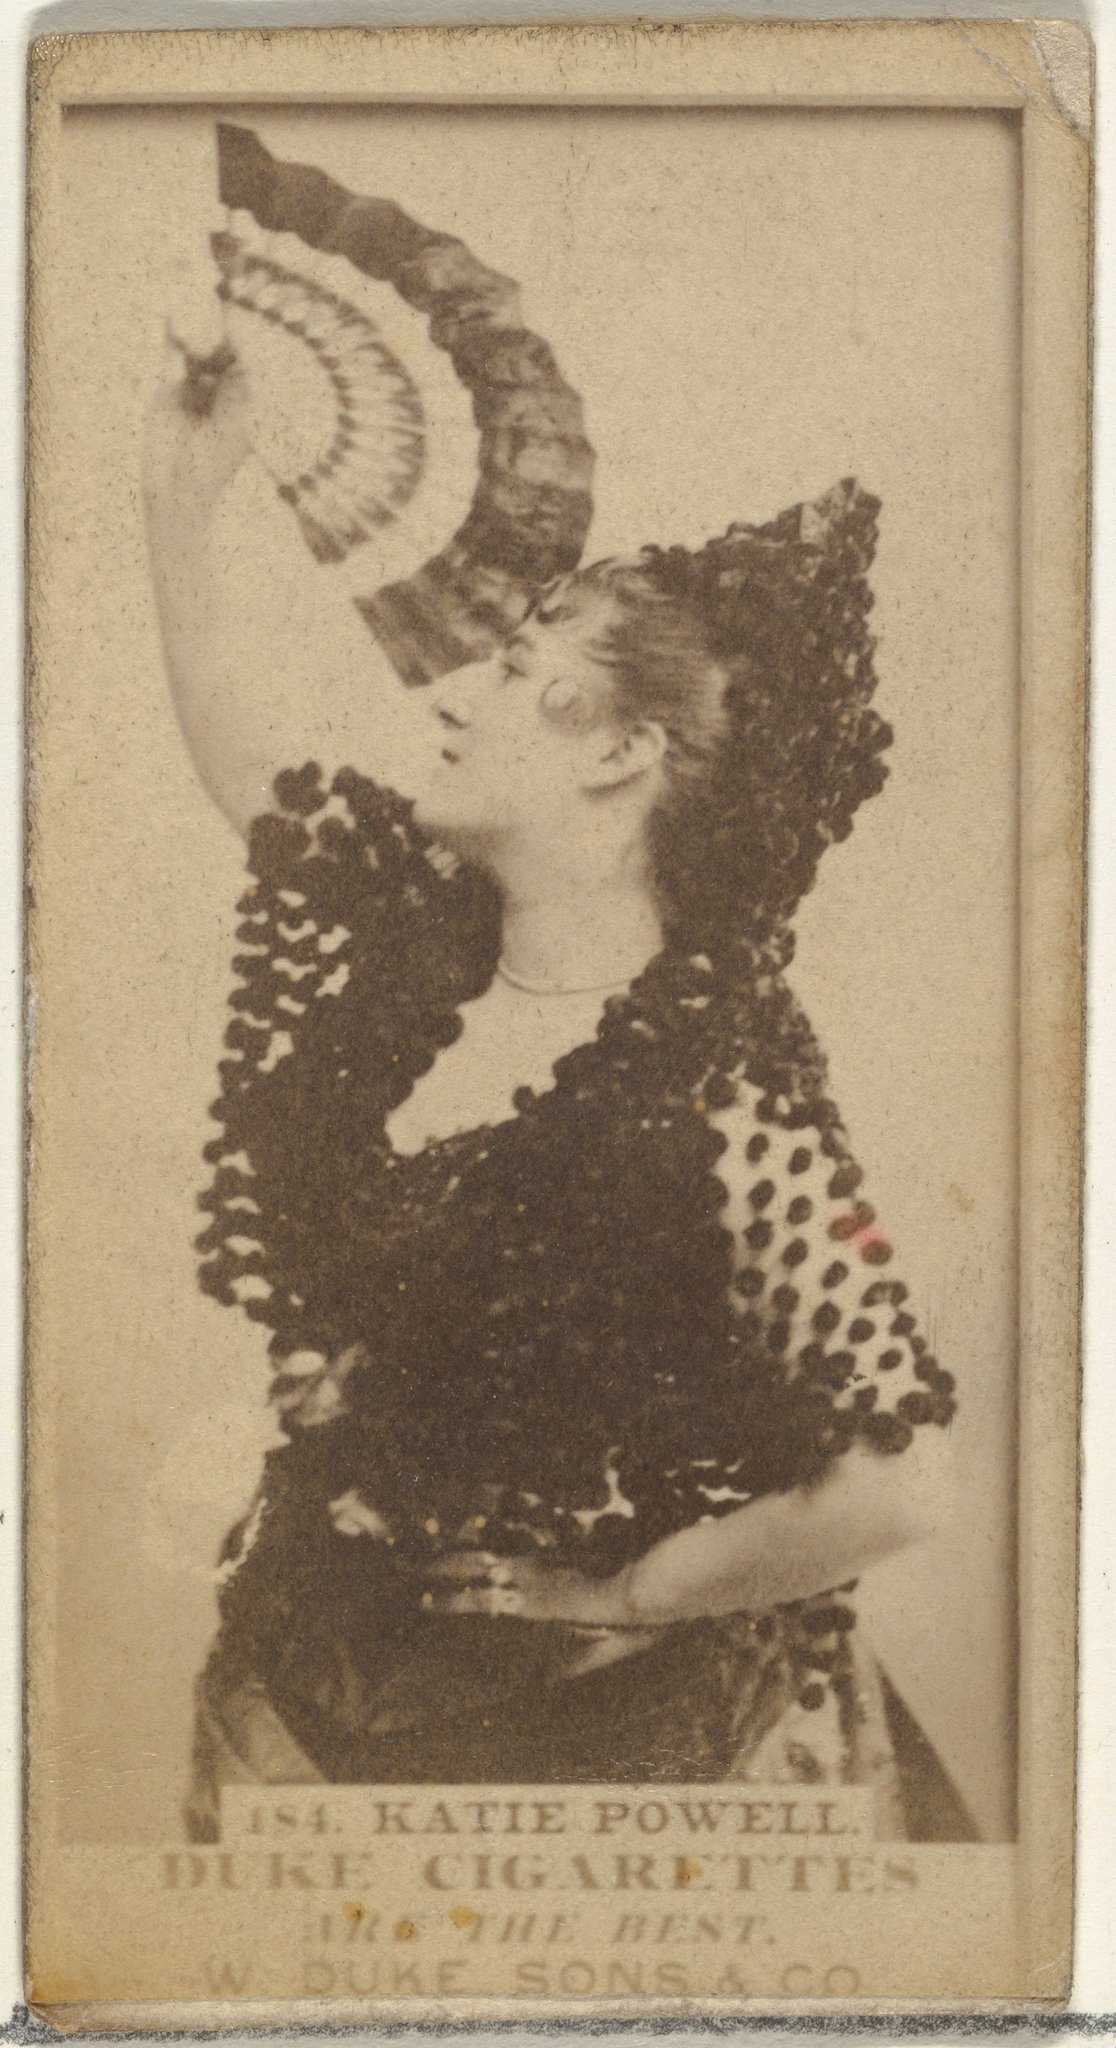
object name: photograph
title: Card Number 184, Katie Powell, from the Actors and Actresses series (N145-7) issued by Duke Sons & Co. to promote Duke Cigarettes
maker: w. duke, sons & co.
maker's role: publisher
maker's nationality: american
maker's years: 1870-1920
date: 1880-1889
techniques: albumen silver print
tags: fans,women,actresses